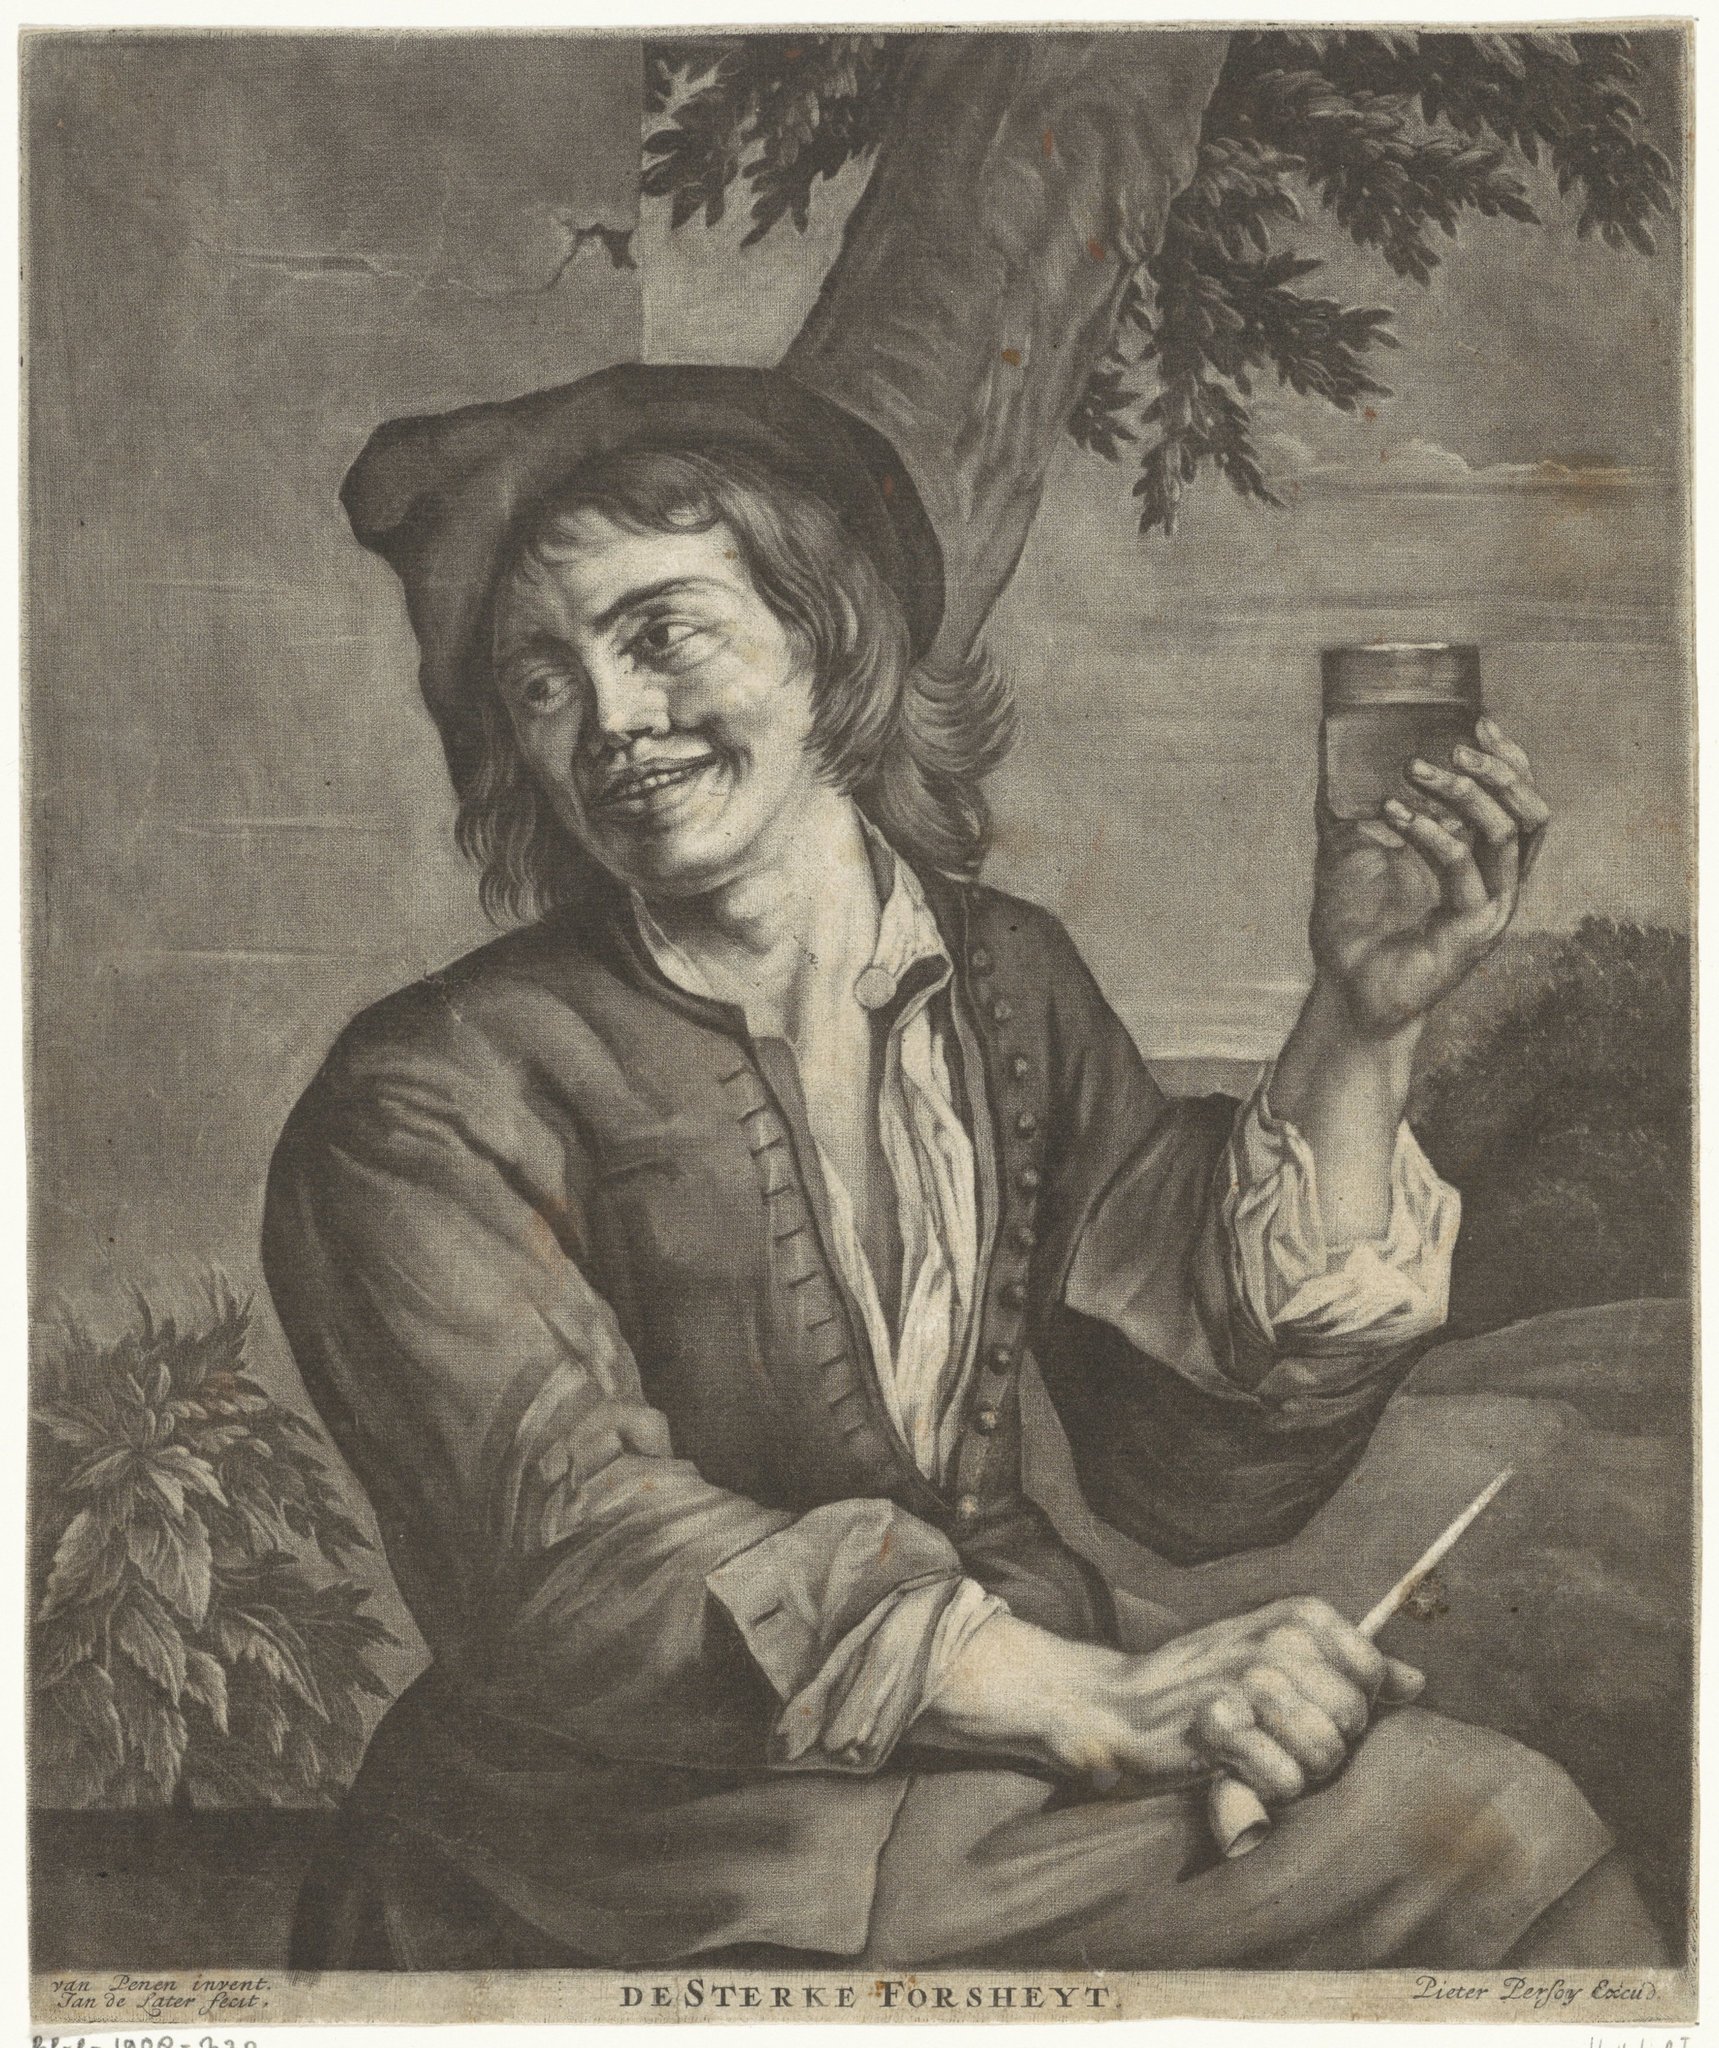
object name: print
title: De Sterke Forsheyt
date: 1680-1694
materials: paper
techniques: engraving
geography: amsterdam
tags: trees, pipe ~ tobacco, smiling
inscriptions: collector's mark: Lugt 2228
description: Een man zit onder een boom met een glas en een pijp in de hand. Hij glimlacht.